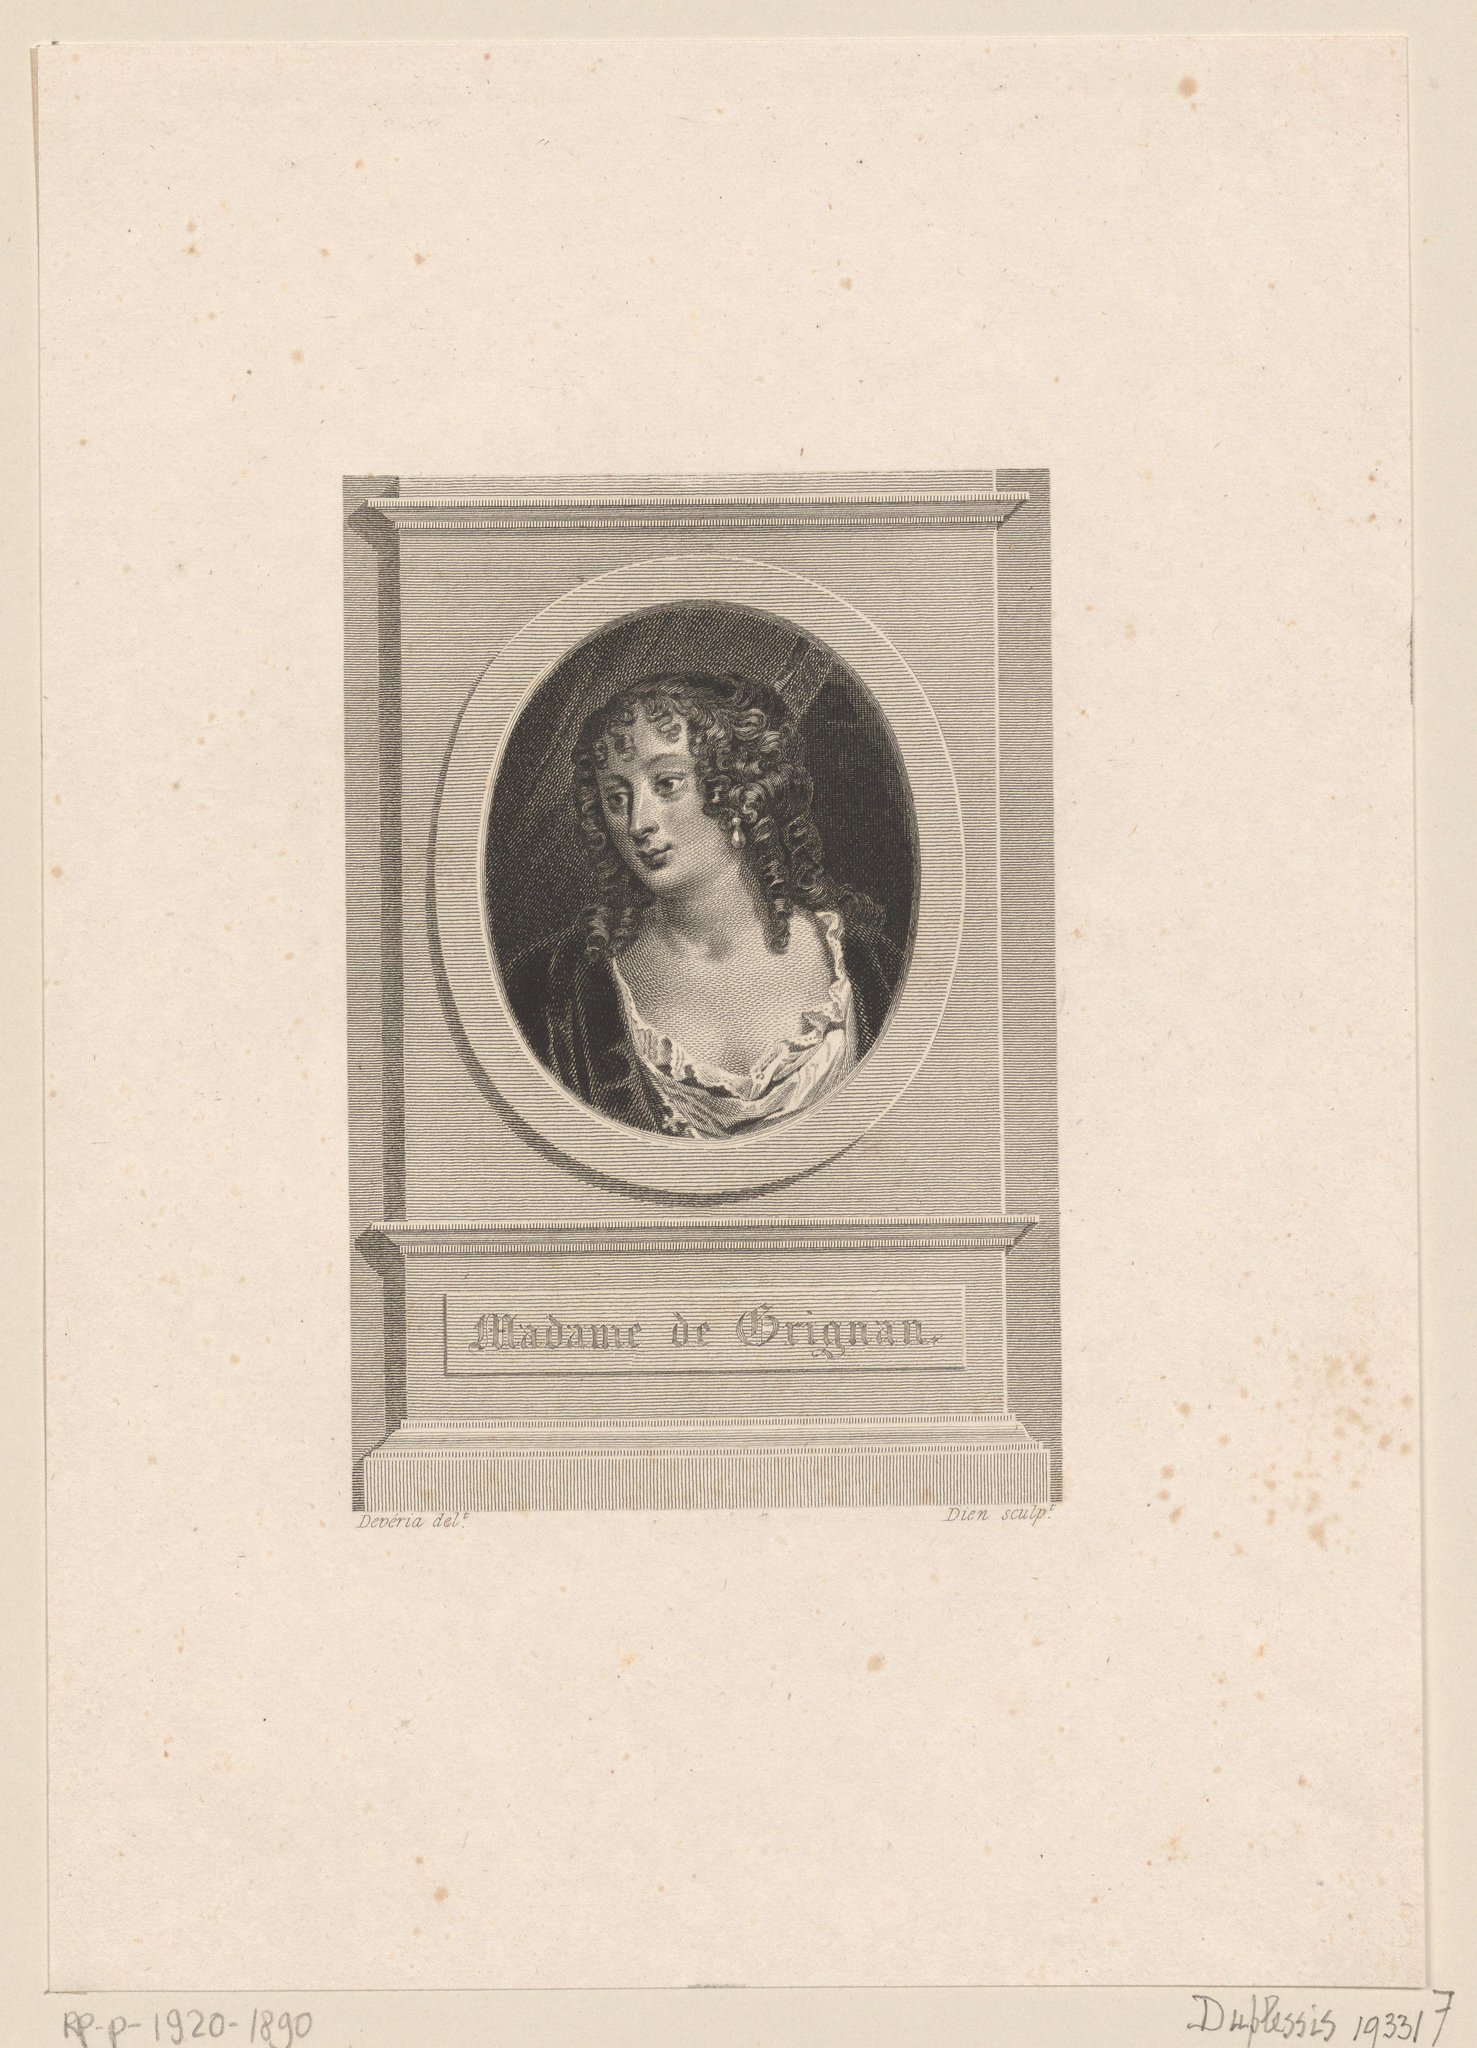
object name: print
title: Portret van Françoise-Marguerite de Sévigné, gravin van Grignan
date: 1797-1865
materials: paper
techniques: engraving, etching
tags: paris, marseille, historical persons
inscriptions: collector's mark: Lugt 2228